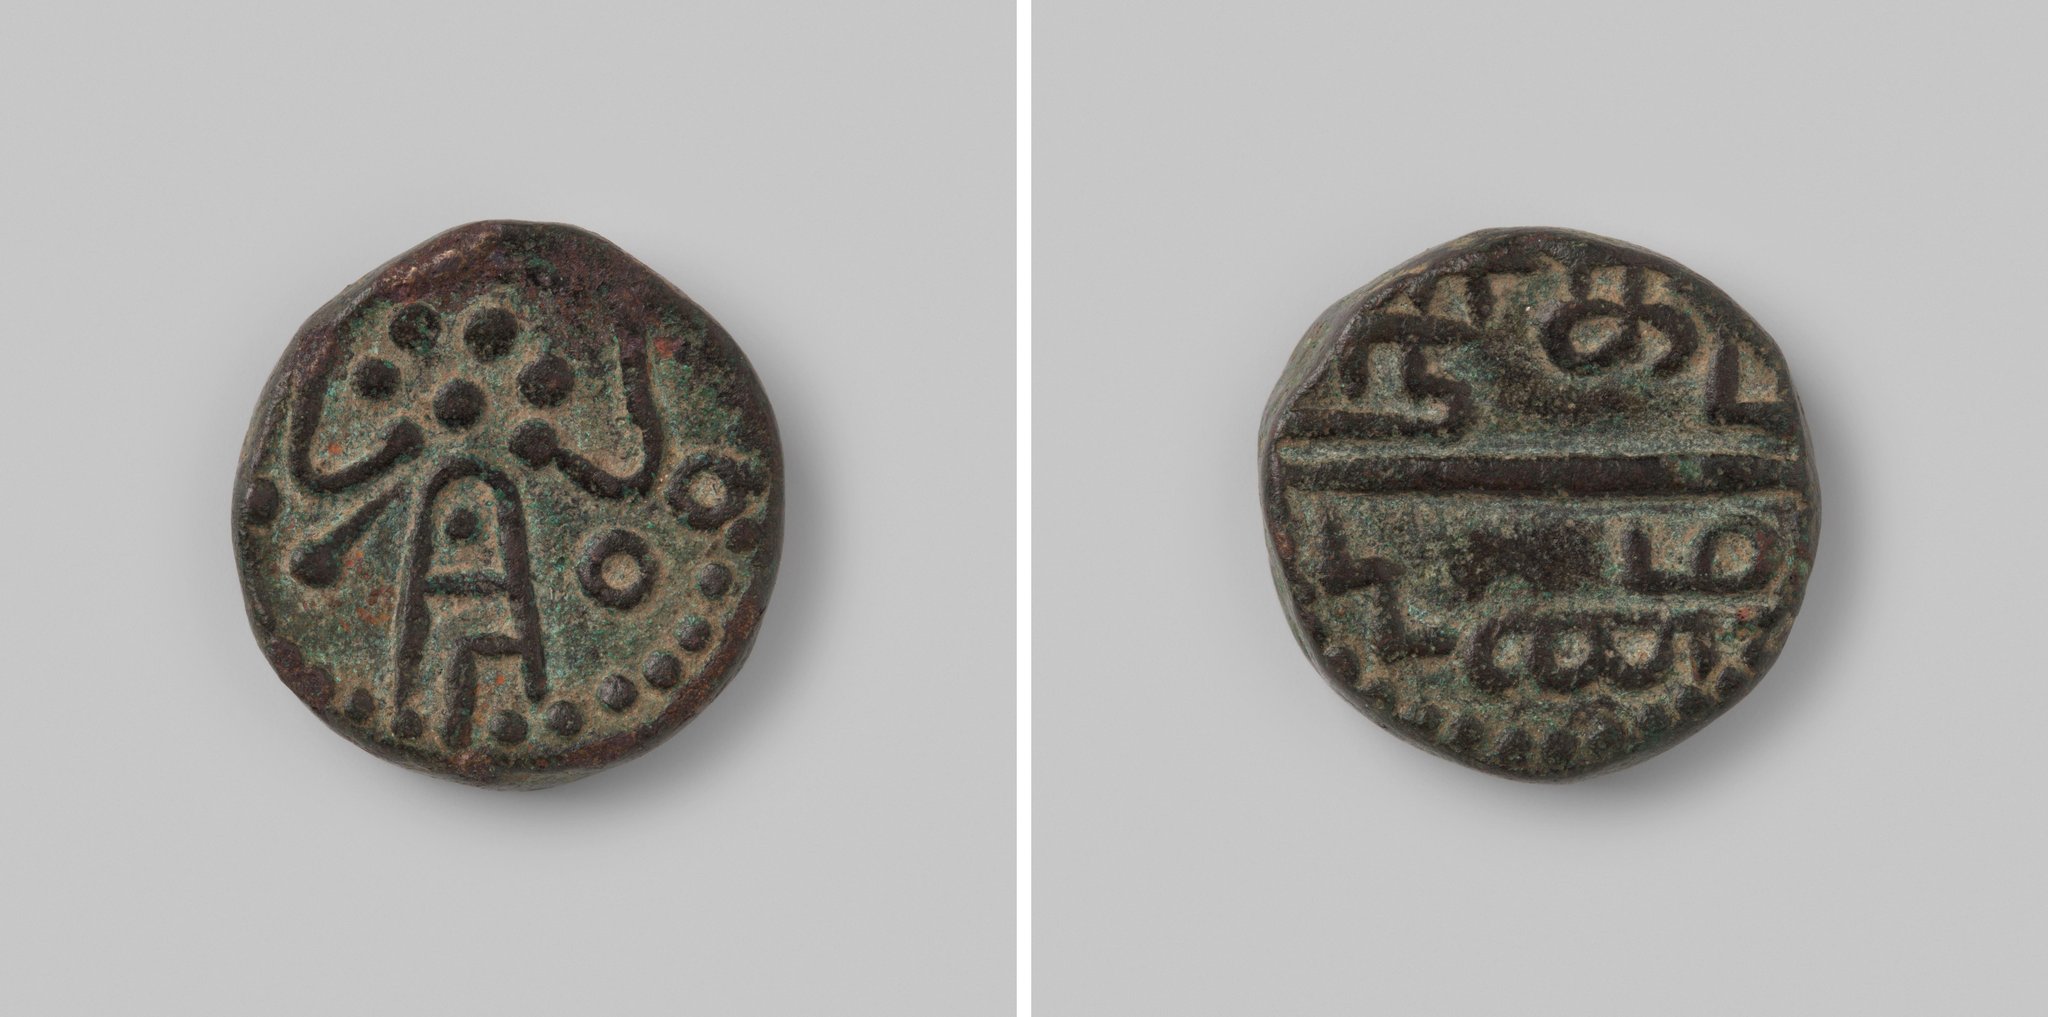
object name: coin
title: Stuiver van Negapatnam voor Ceylon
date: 1695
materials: copper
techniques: striking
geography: negapatnam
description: Koperen munt. Voorzijde: verbasterde menselijke figuur (Kali). Boven de linkerschouder twee cirkels schuin boven elkaar. Keerzijde: tweeregelig opschrift in Tamil. Gladde rand.